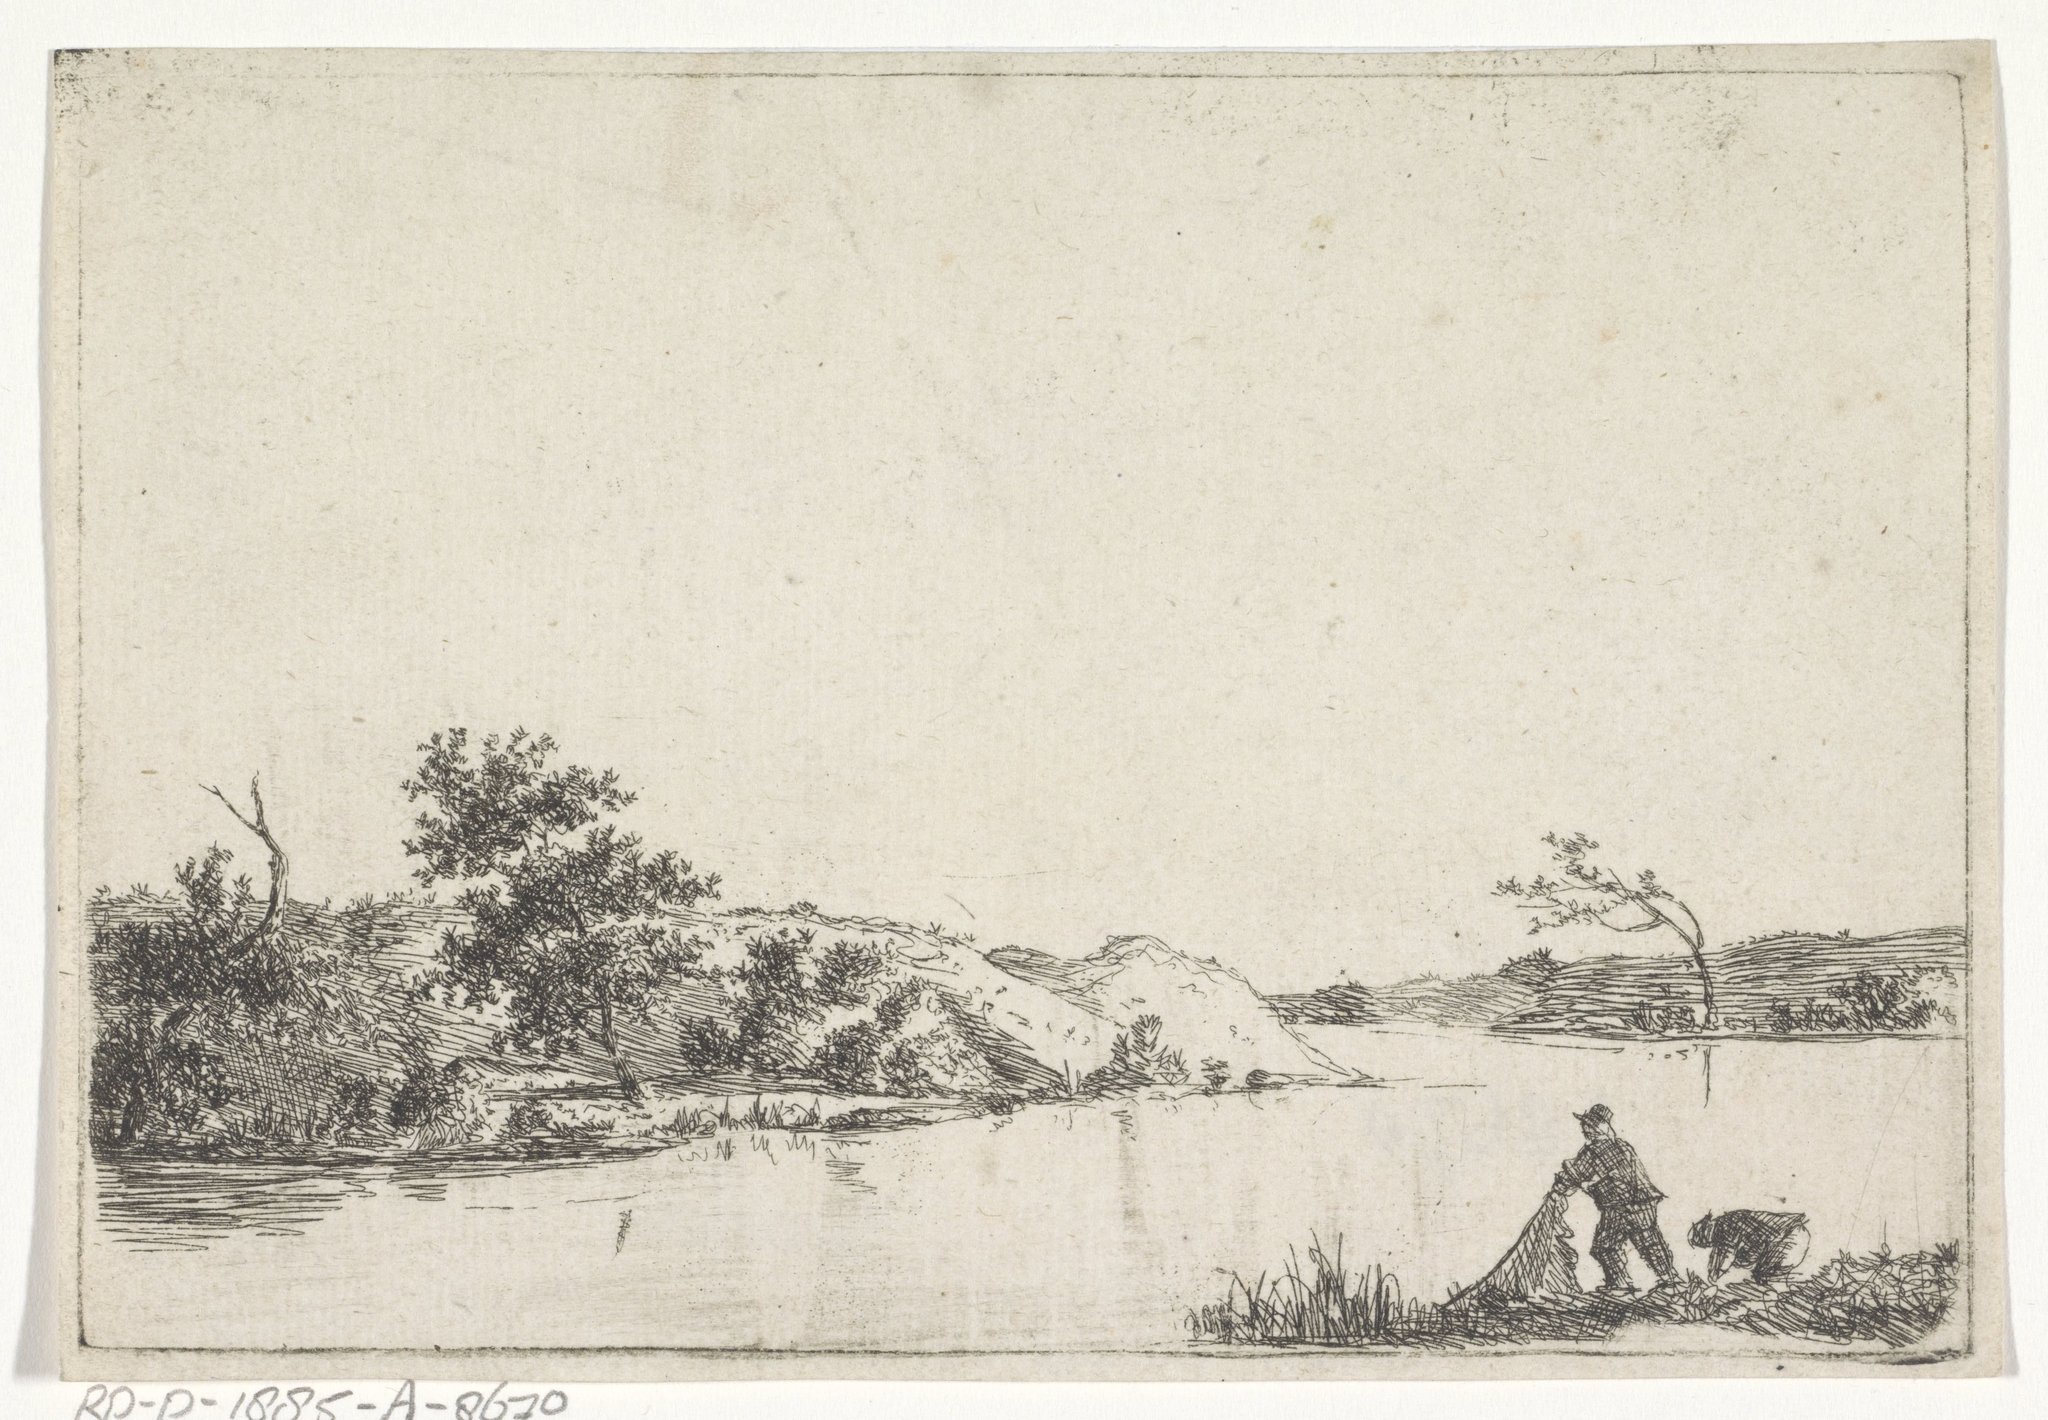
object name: print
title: Landschap met twee vissers met net bij het water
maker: Anonymous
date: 1600-1800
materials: paper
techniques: etching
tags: fishing net, landscapes in the temperate zone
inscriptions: collector's mark: Lugt 2228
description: Landschap met op de voorgrond twee vissers met net bij het water.